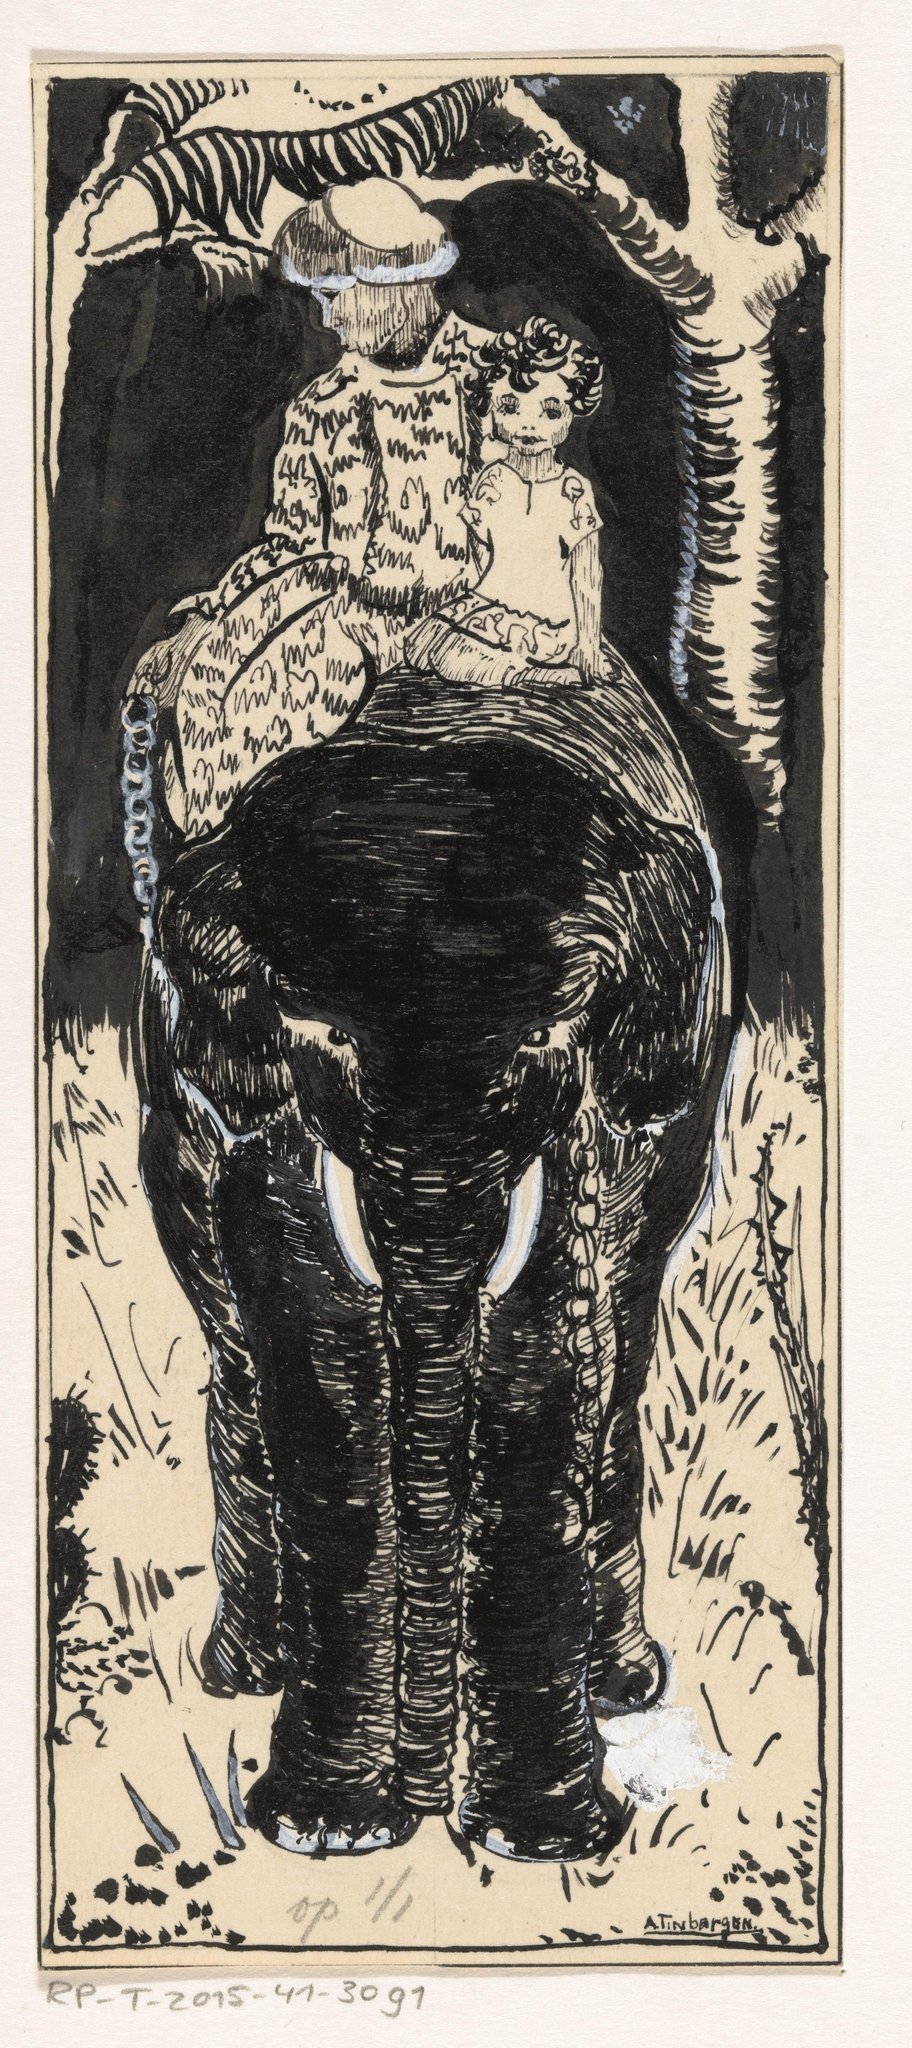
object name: drawing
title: Man en kind op een olifant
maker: a. tinbergen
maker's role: draughtsman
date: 1925-1935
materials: paint, ink, paper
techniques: brush, pen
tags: trunked animals: elephant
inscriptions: collector's mark: Lugt 2228a, signature: ‘A.TINBERGEN.’, :